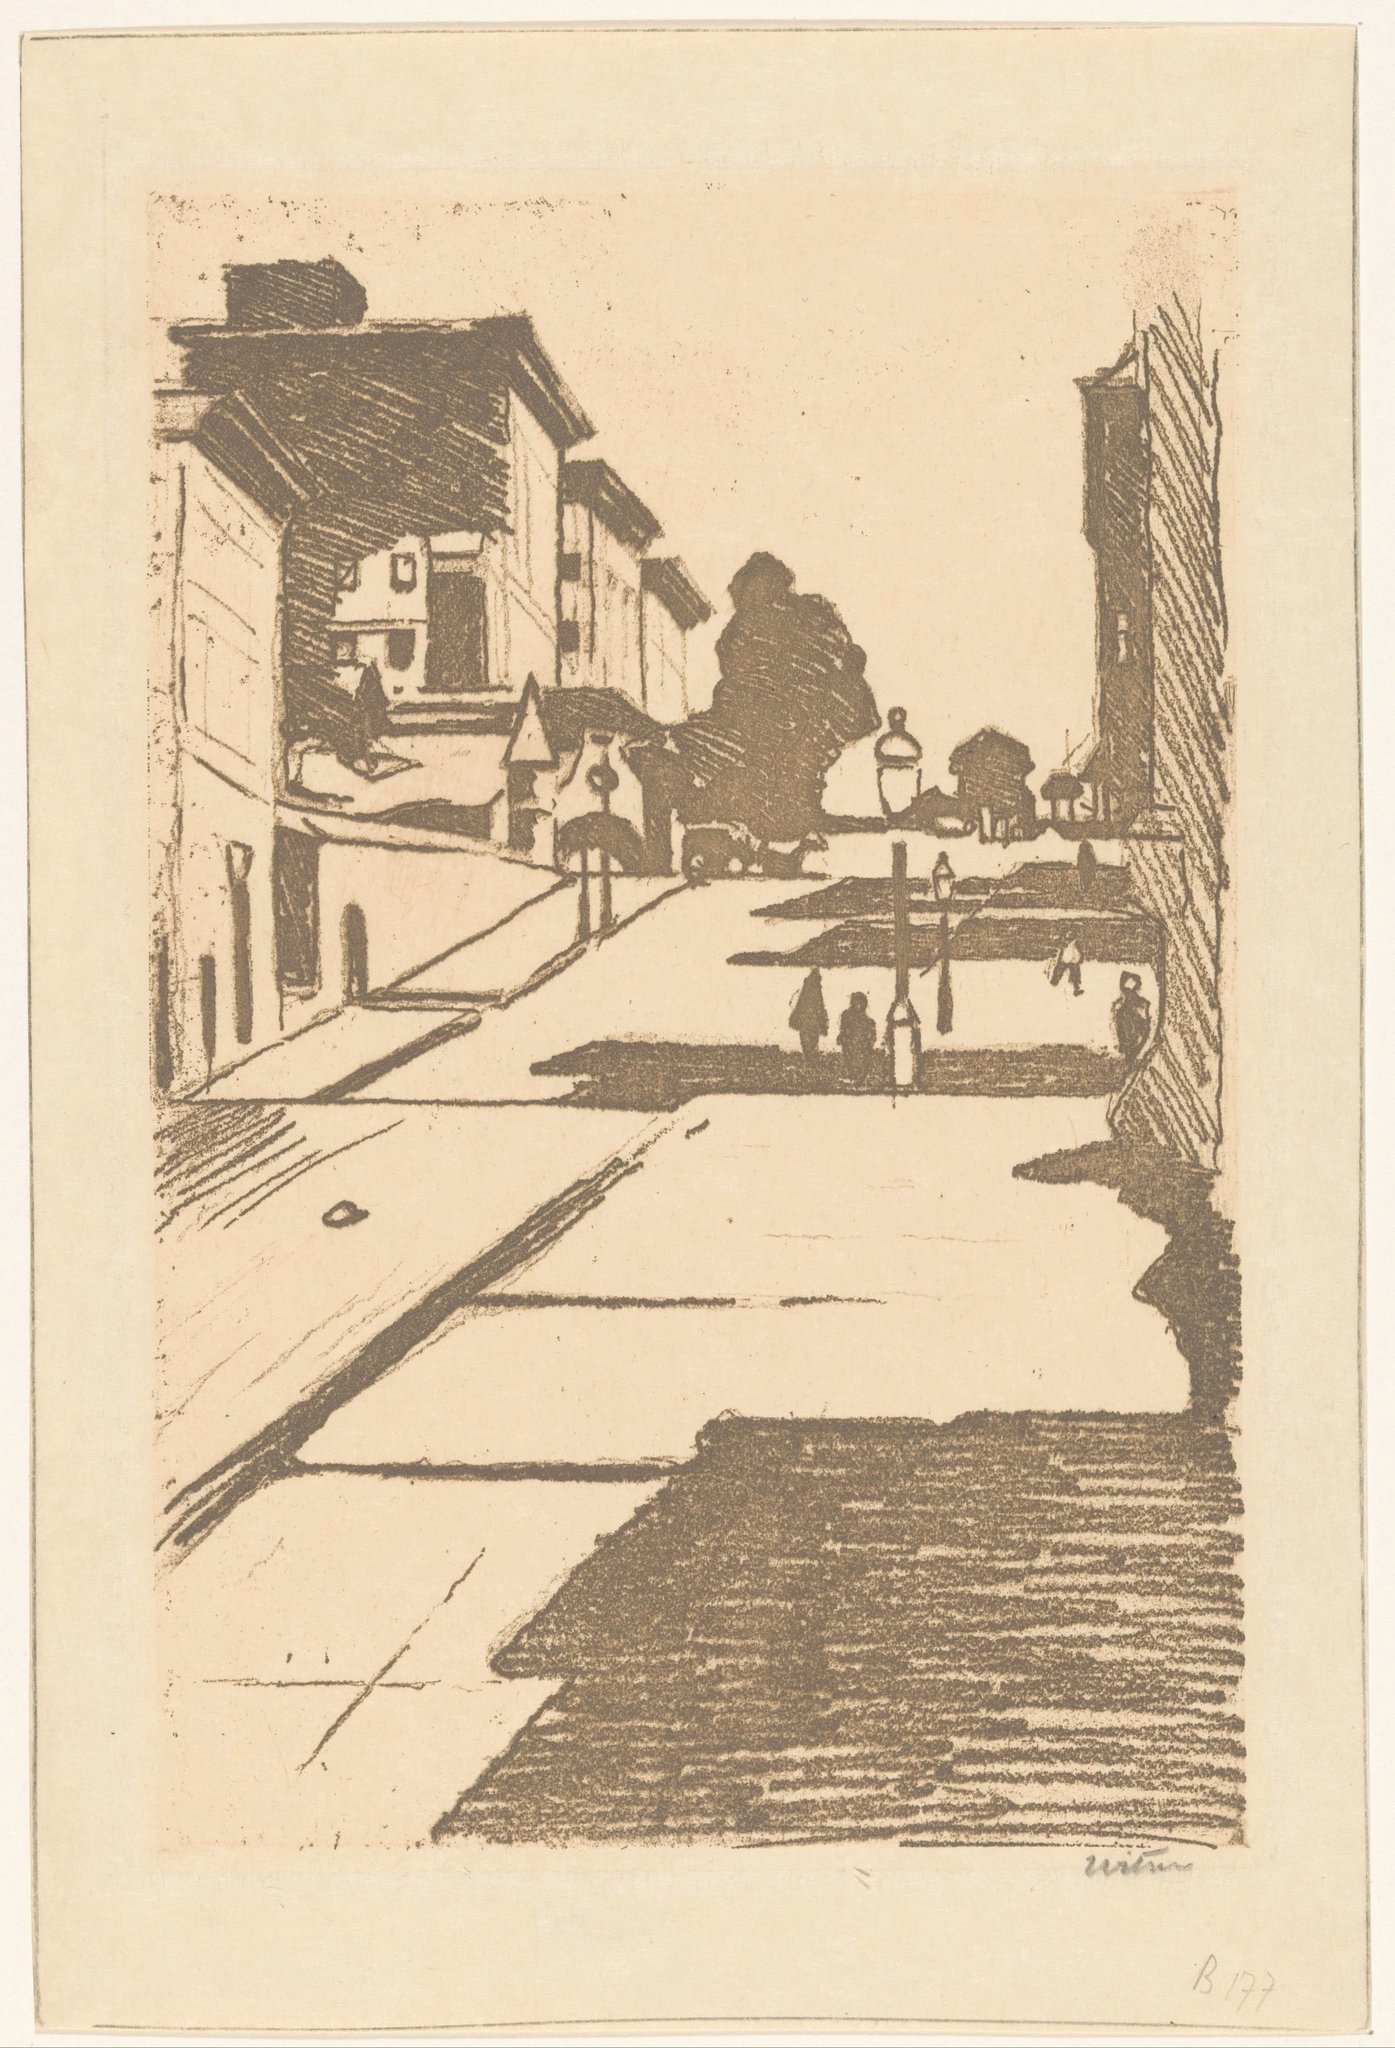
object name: print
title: Gezicht op Mason Street en het Fairmont hotel in San Francisco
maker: willem witsen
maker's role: draughtsman, painter, print maker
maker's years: 1860-1923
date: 1915-1919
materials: paper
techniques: soft ground etching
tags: street, hotel, hostelry, inn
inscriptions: signature: ‘Witsen’, collector's mark: Lugt 2228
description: Gezien vanaf Mason Street richting California Street.